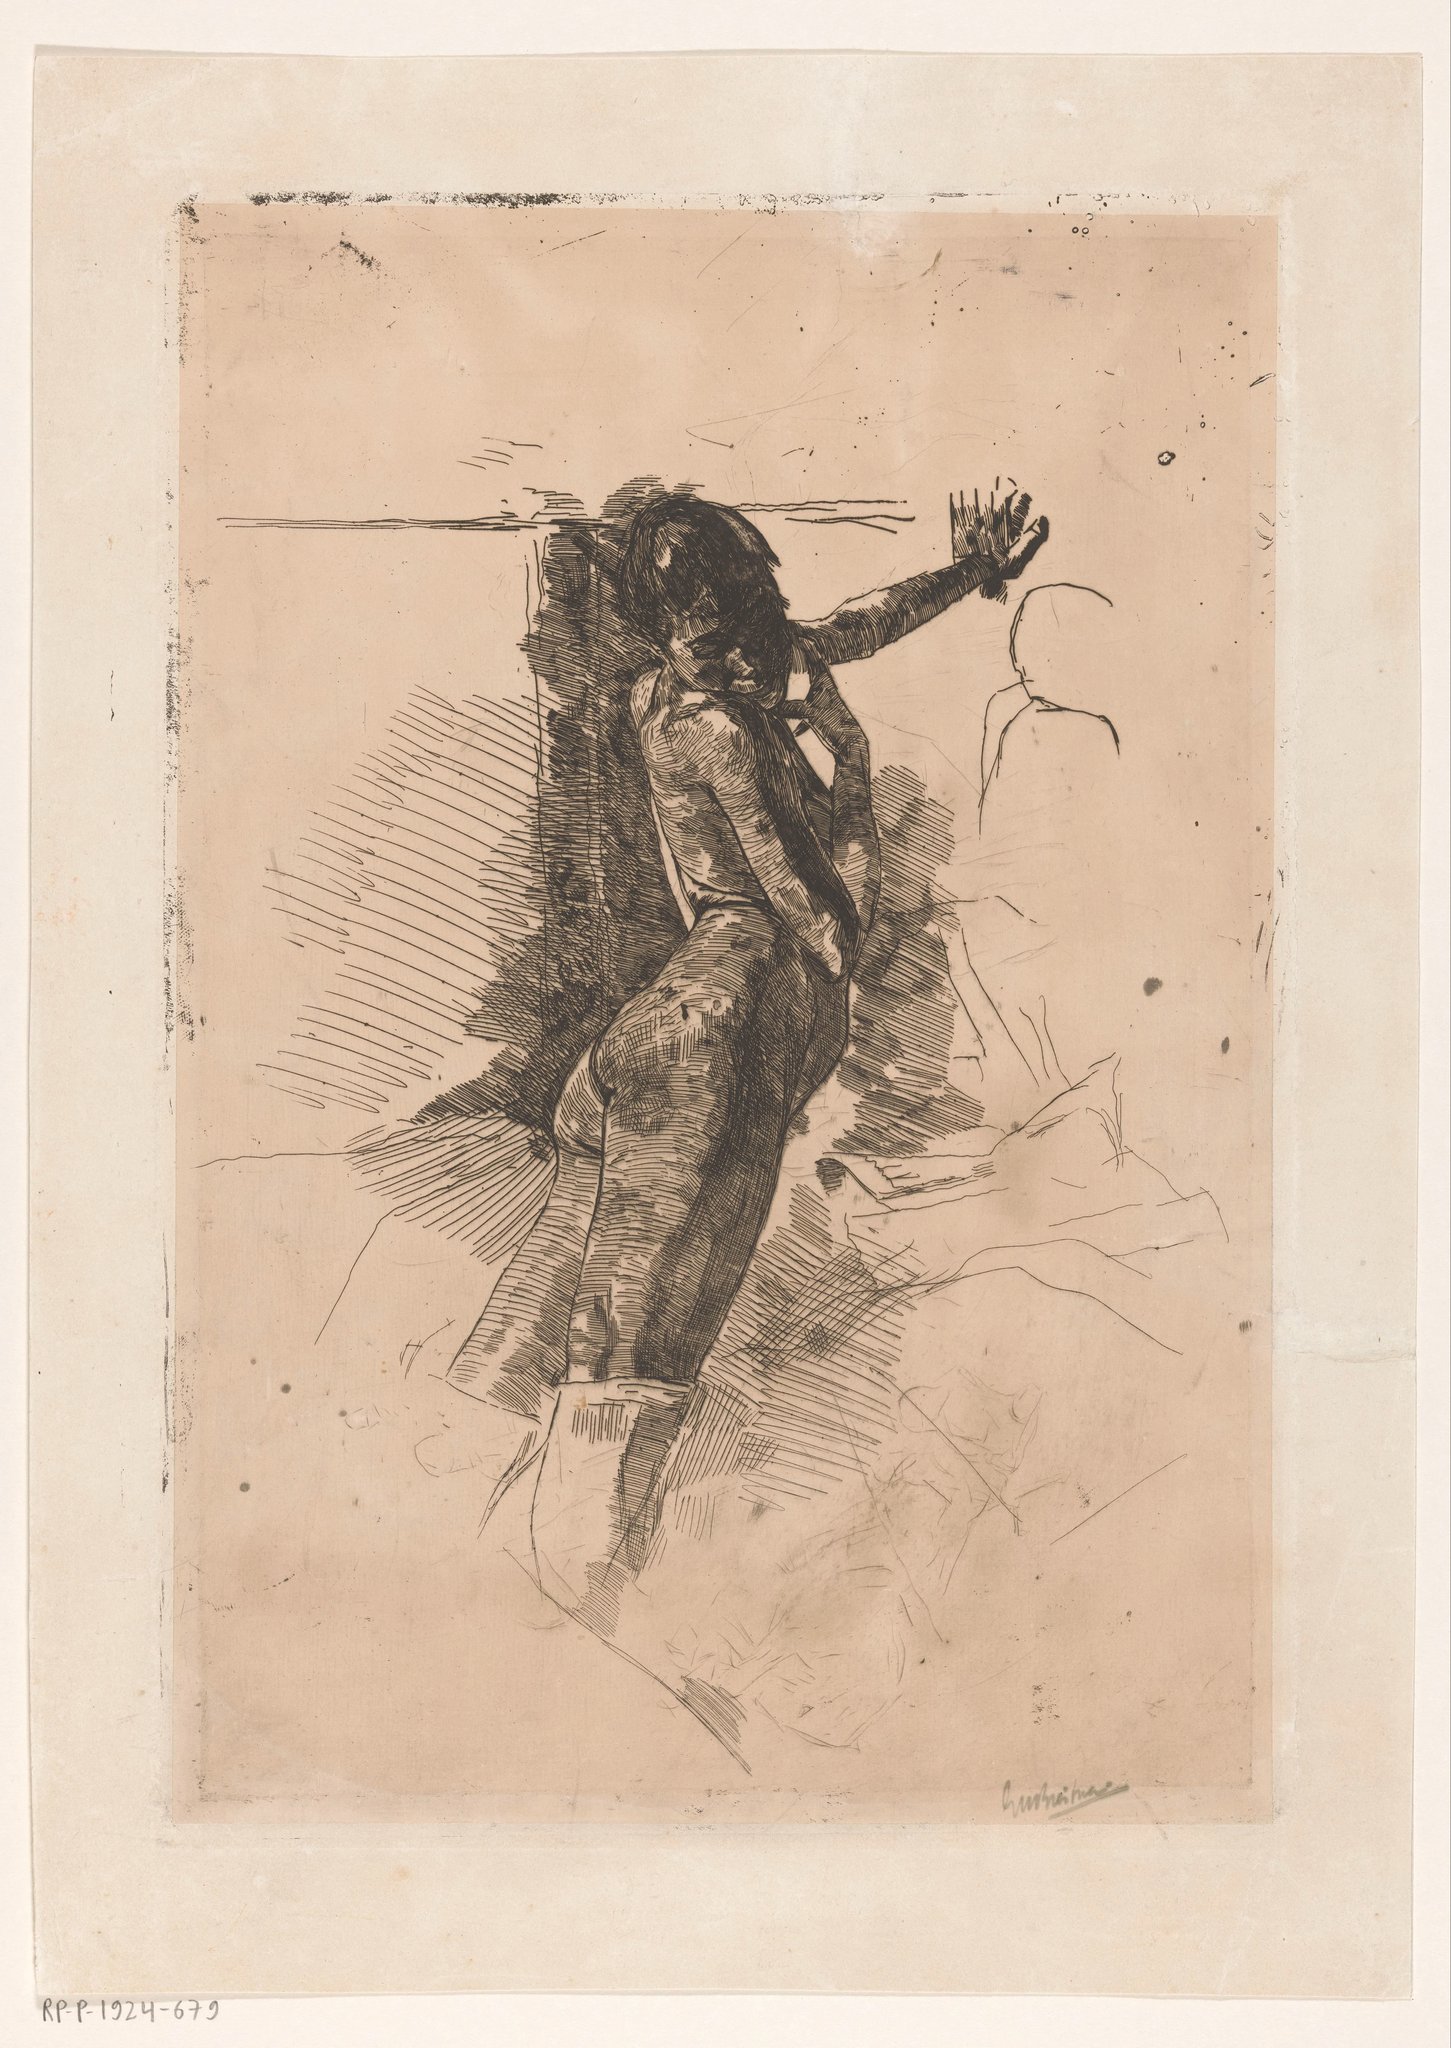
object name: print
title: Staande, naakte vrouw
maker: george hendrik breitner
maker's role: draughtsman, painter, print maker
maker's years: 1857-1923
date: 1891-1893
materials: paper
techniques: etching, intaglio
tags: woman (showing herself) undressed, quasi-nude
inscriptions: collector's mark: Lugt 2228